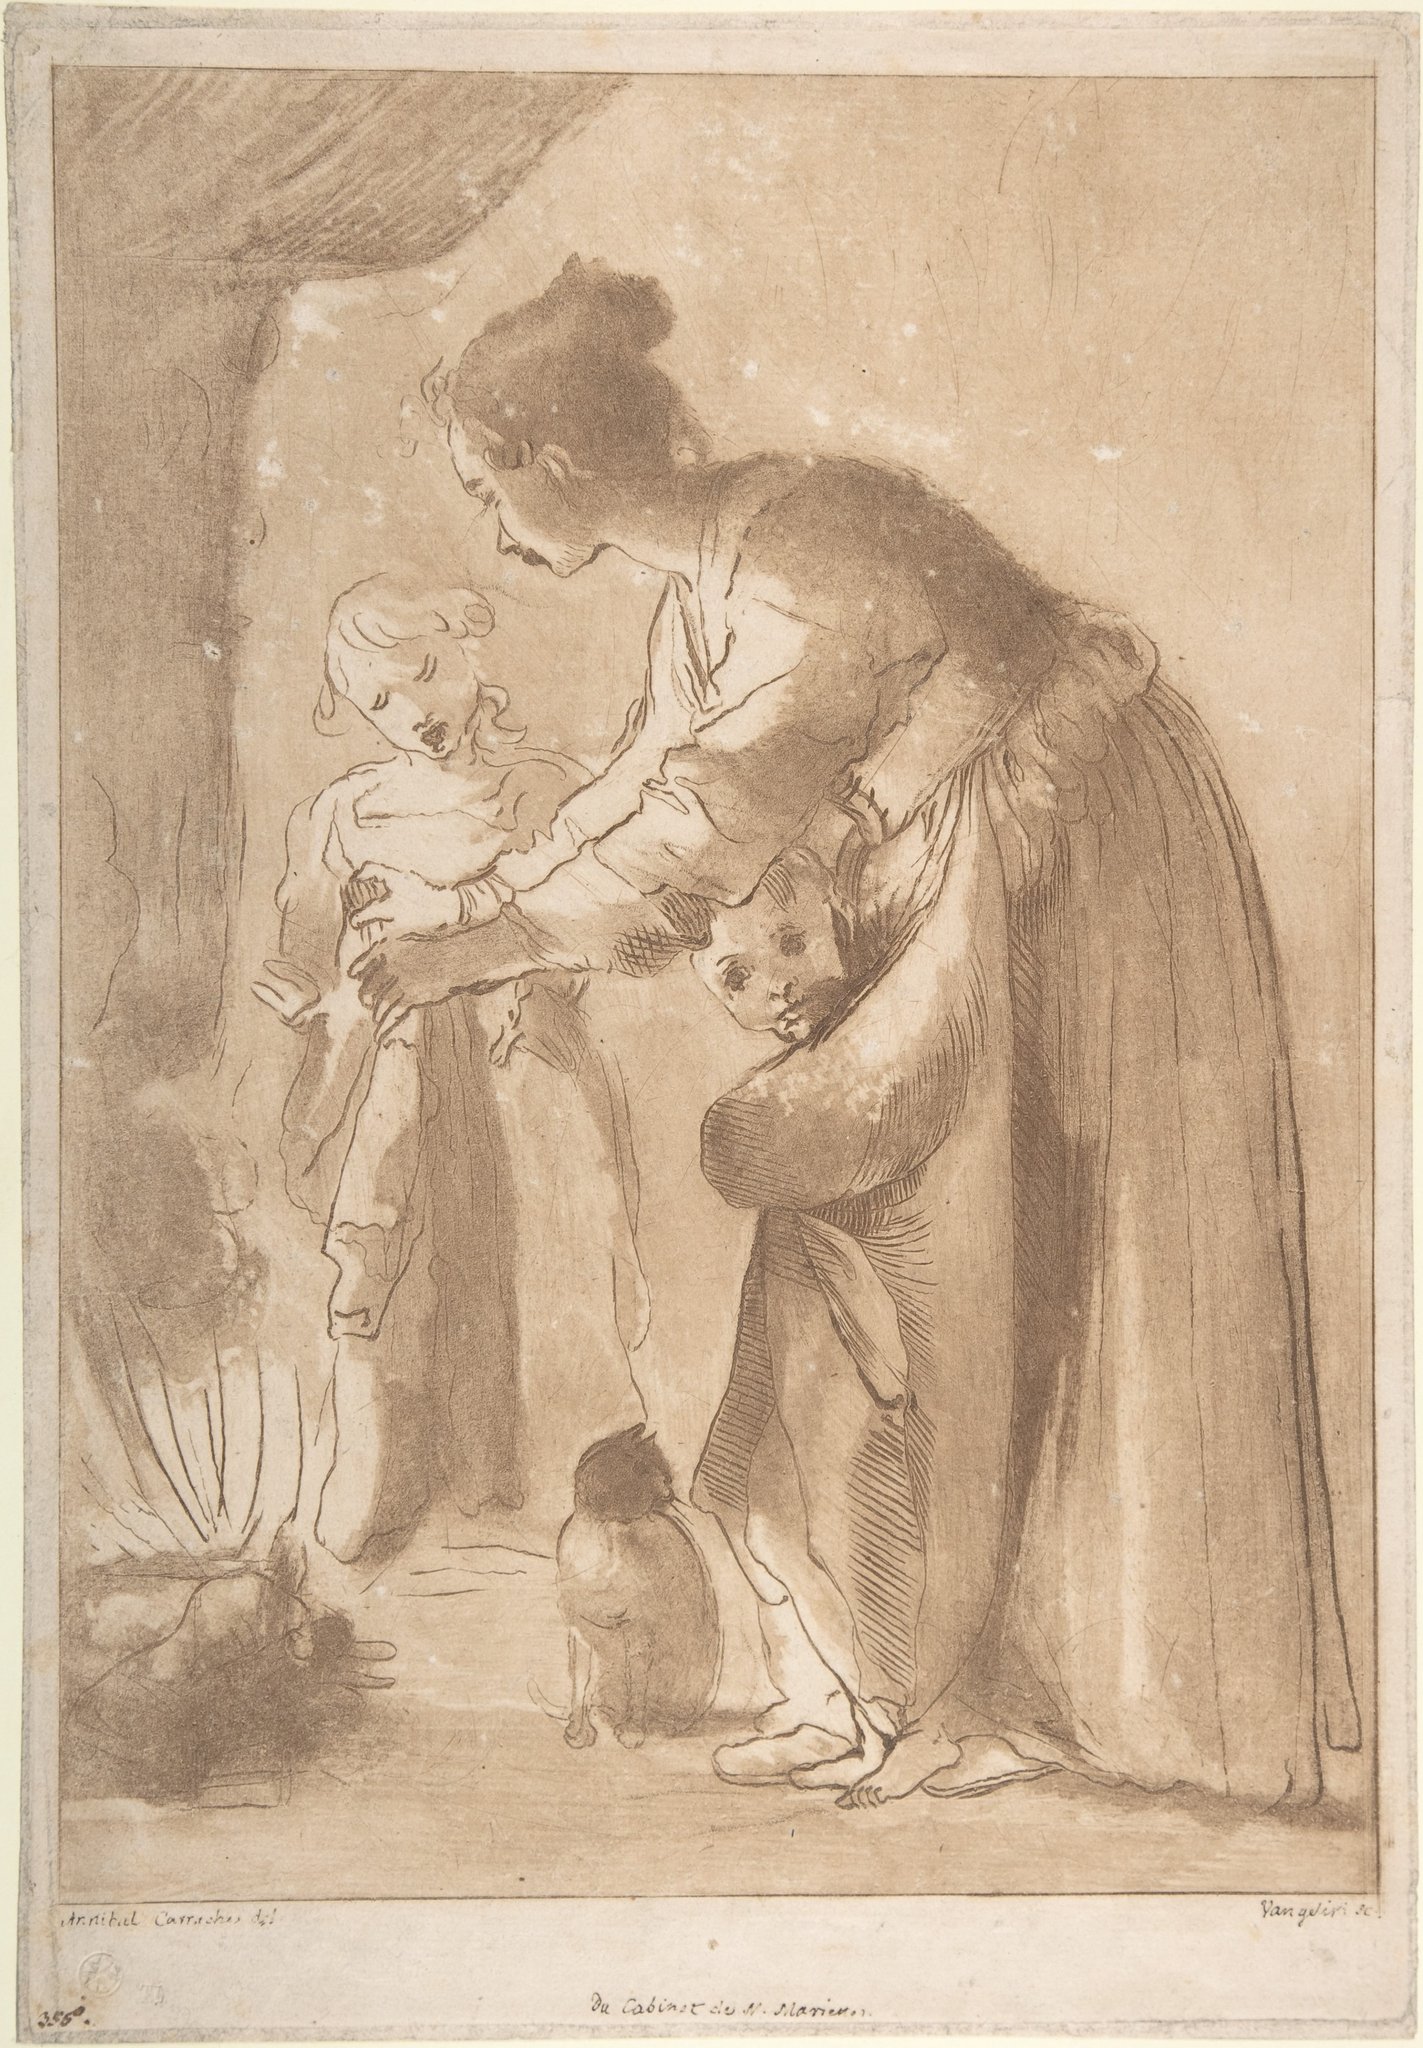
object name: print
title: A Domestic Scene: Woman Warming Clothes and Children in Front of a Fire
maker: vincenzio vangelisti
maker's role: artist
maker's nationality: italian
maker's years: 1728-1798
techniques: engraving, etching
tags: girls,women,cats,fire,daily life